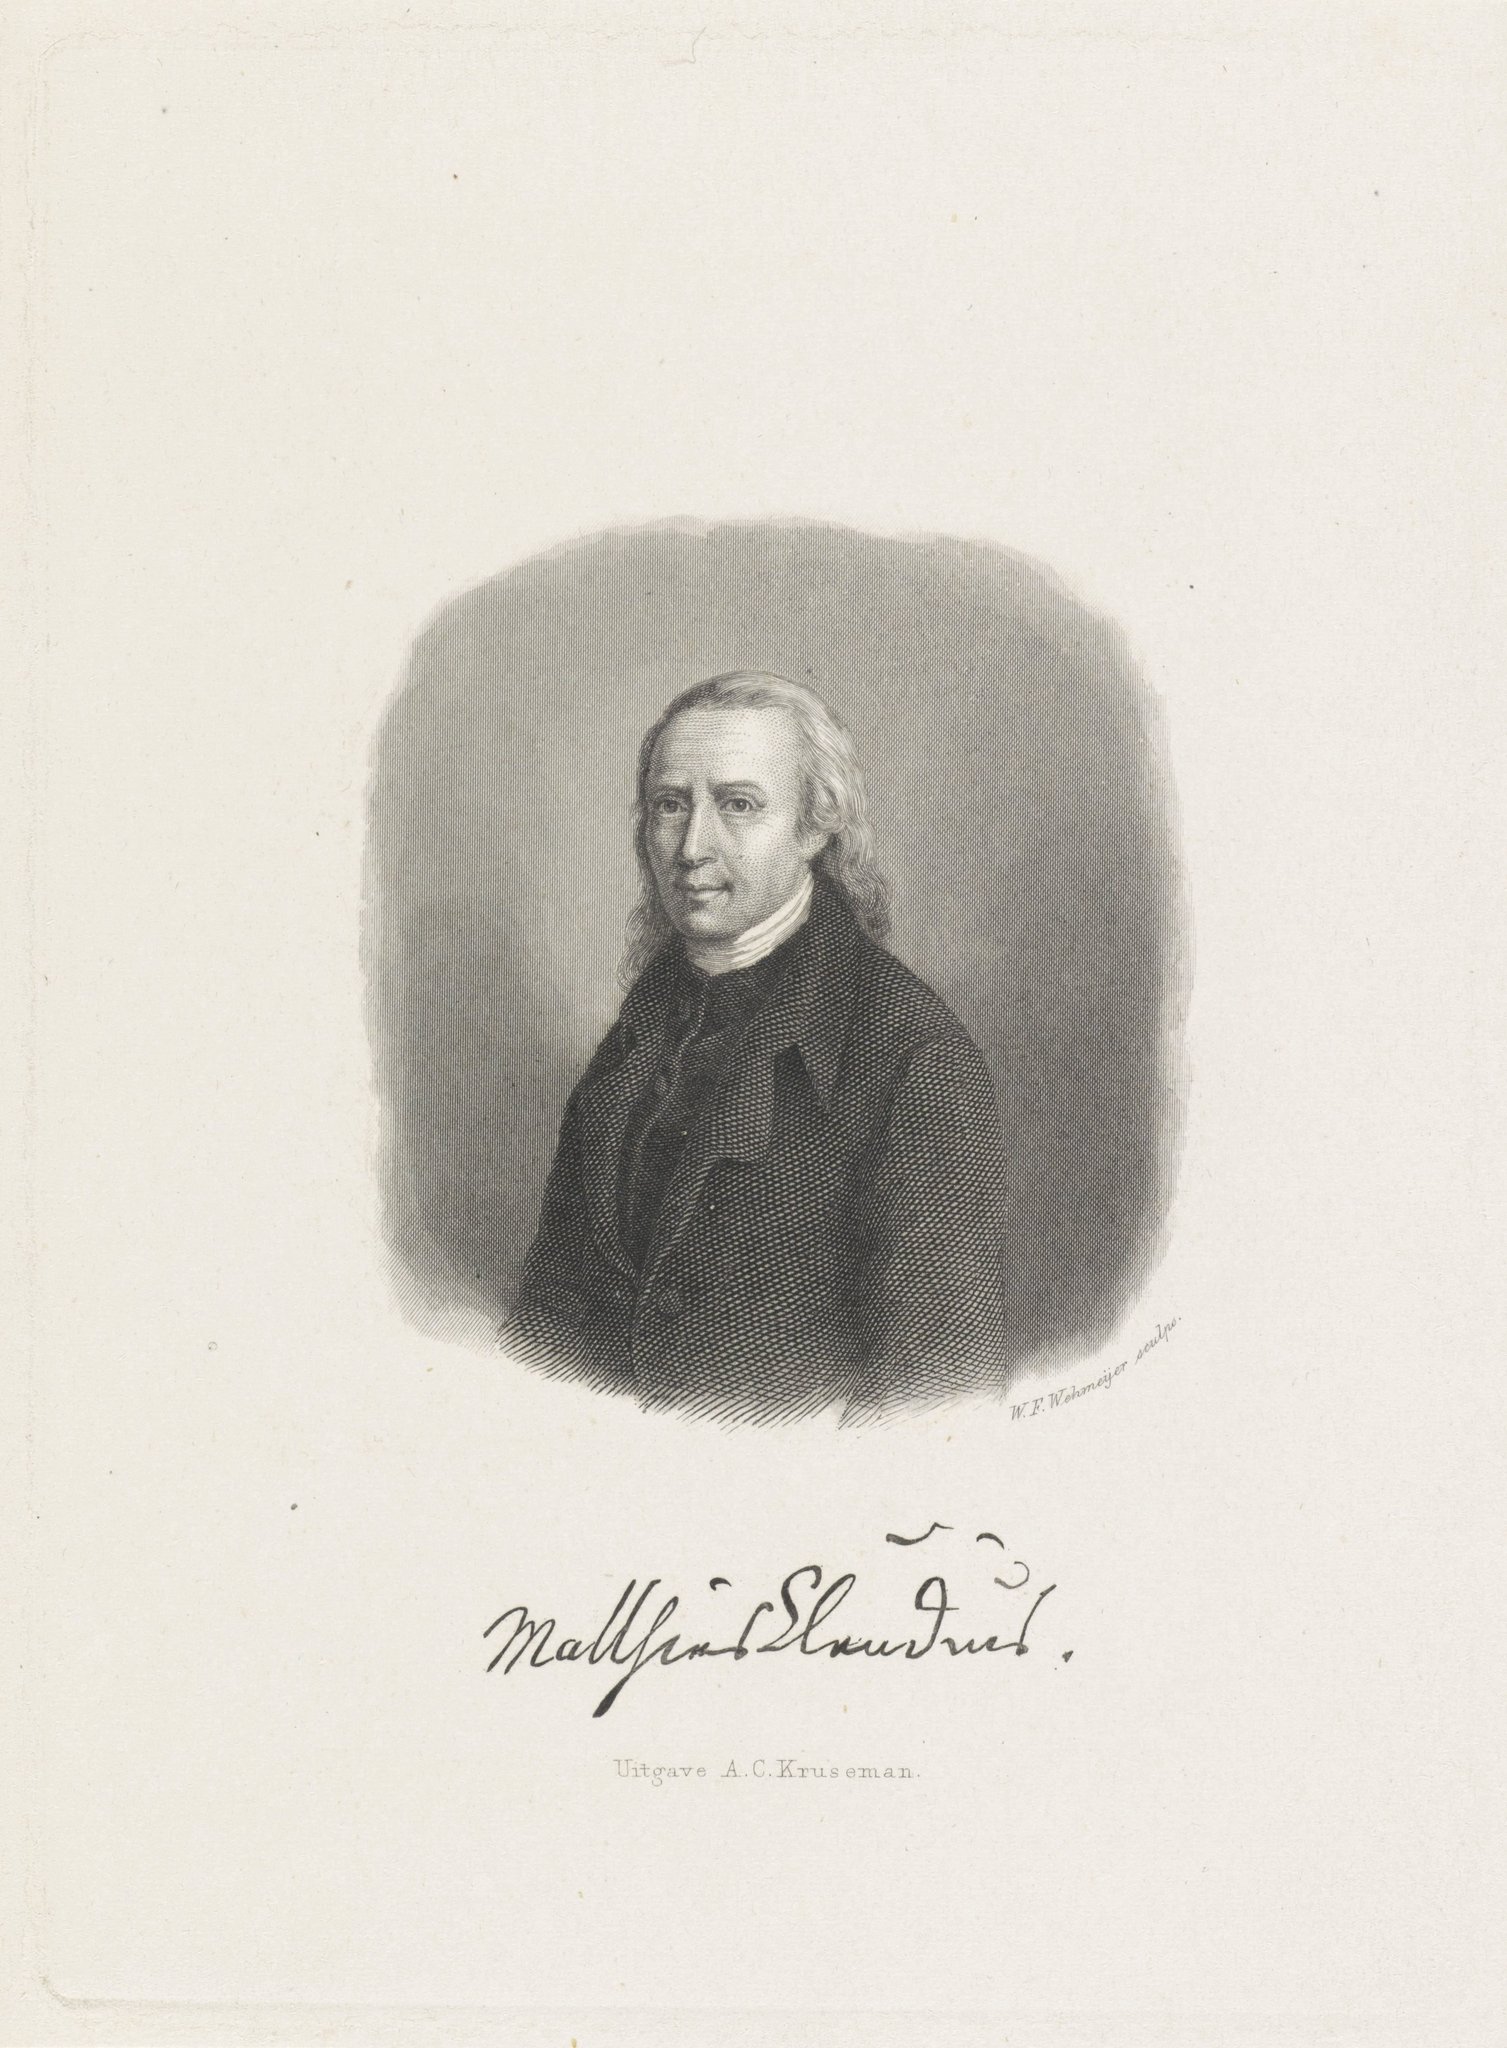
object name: print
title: Portret van Matthias Claudius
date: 1842-1873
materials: paper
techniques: engraving, etching, roulette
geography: amsterdam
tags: draughtsman, matthias claudius, adult man, historical persons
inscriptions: collector's mark: Lugt 2228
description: Portret van Matthias Claudius, Duitse dichter en journalist. Onder de voorstelling de signatuur van de geportretteerde.